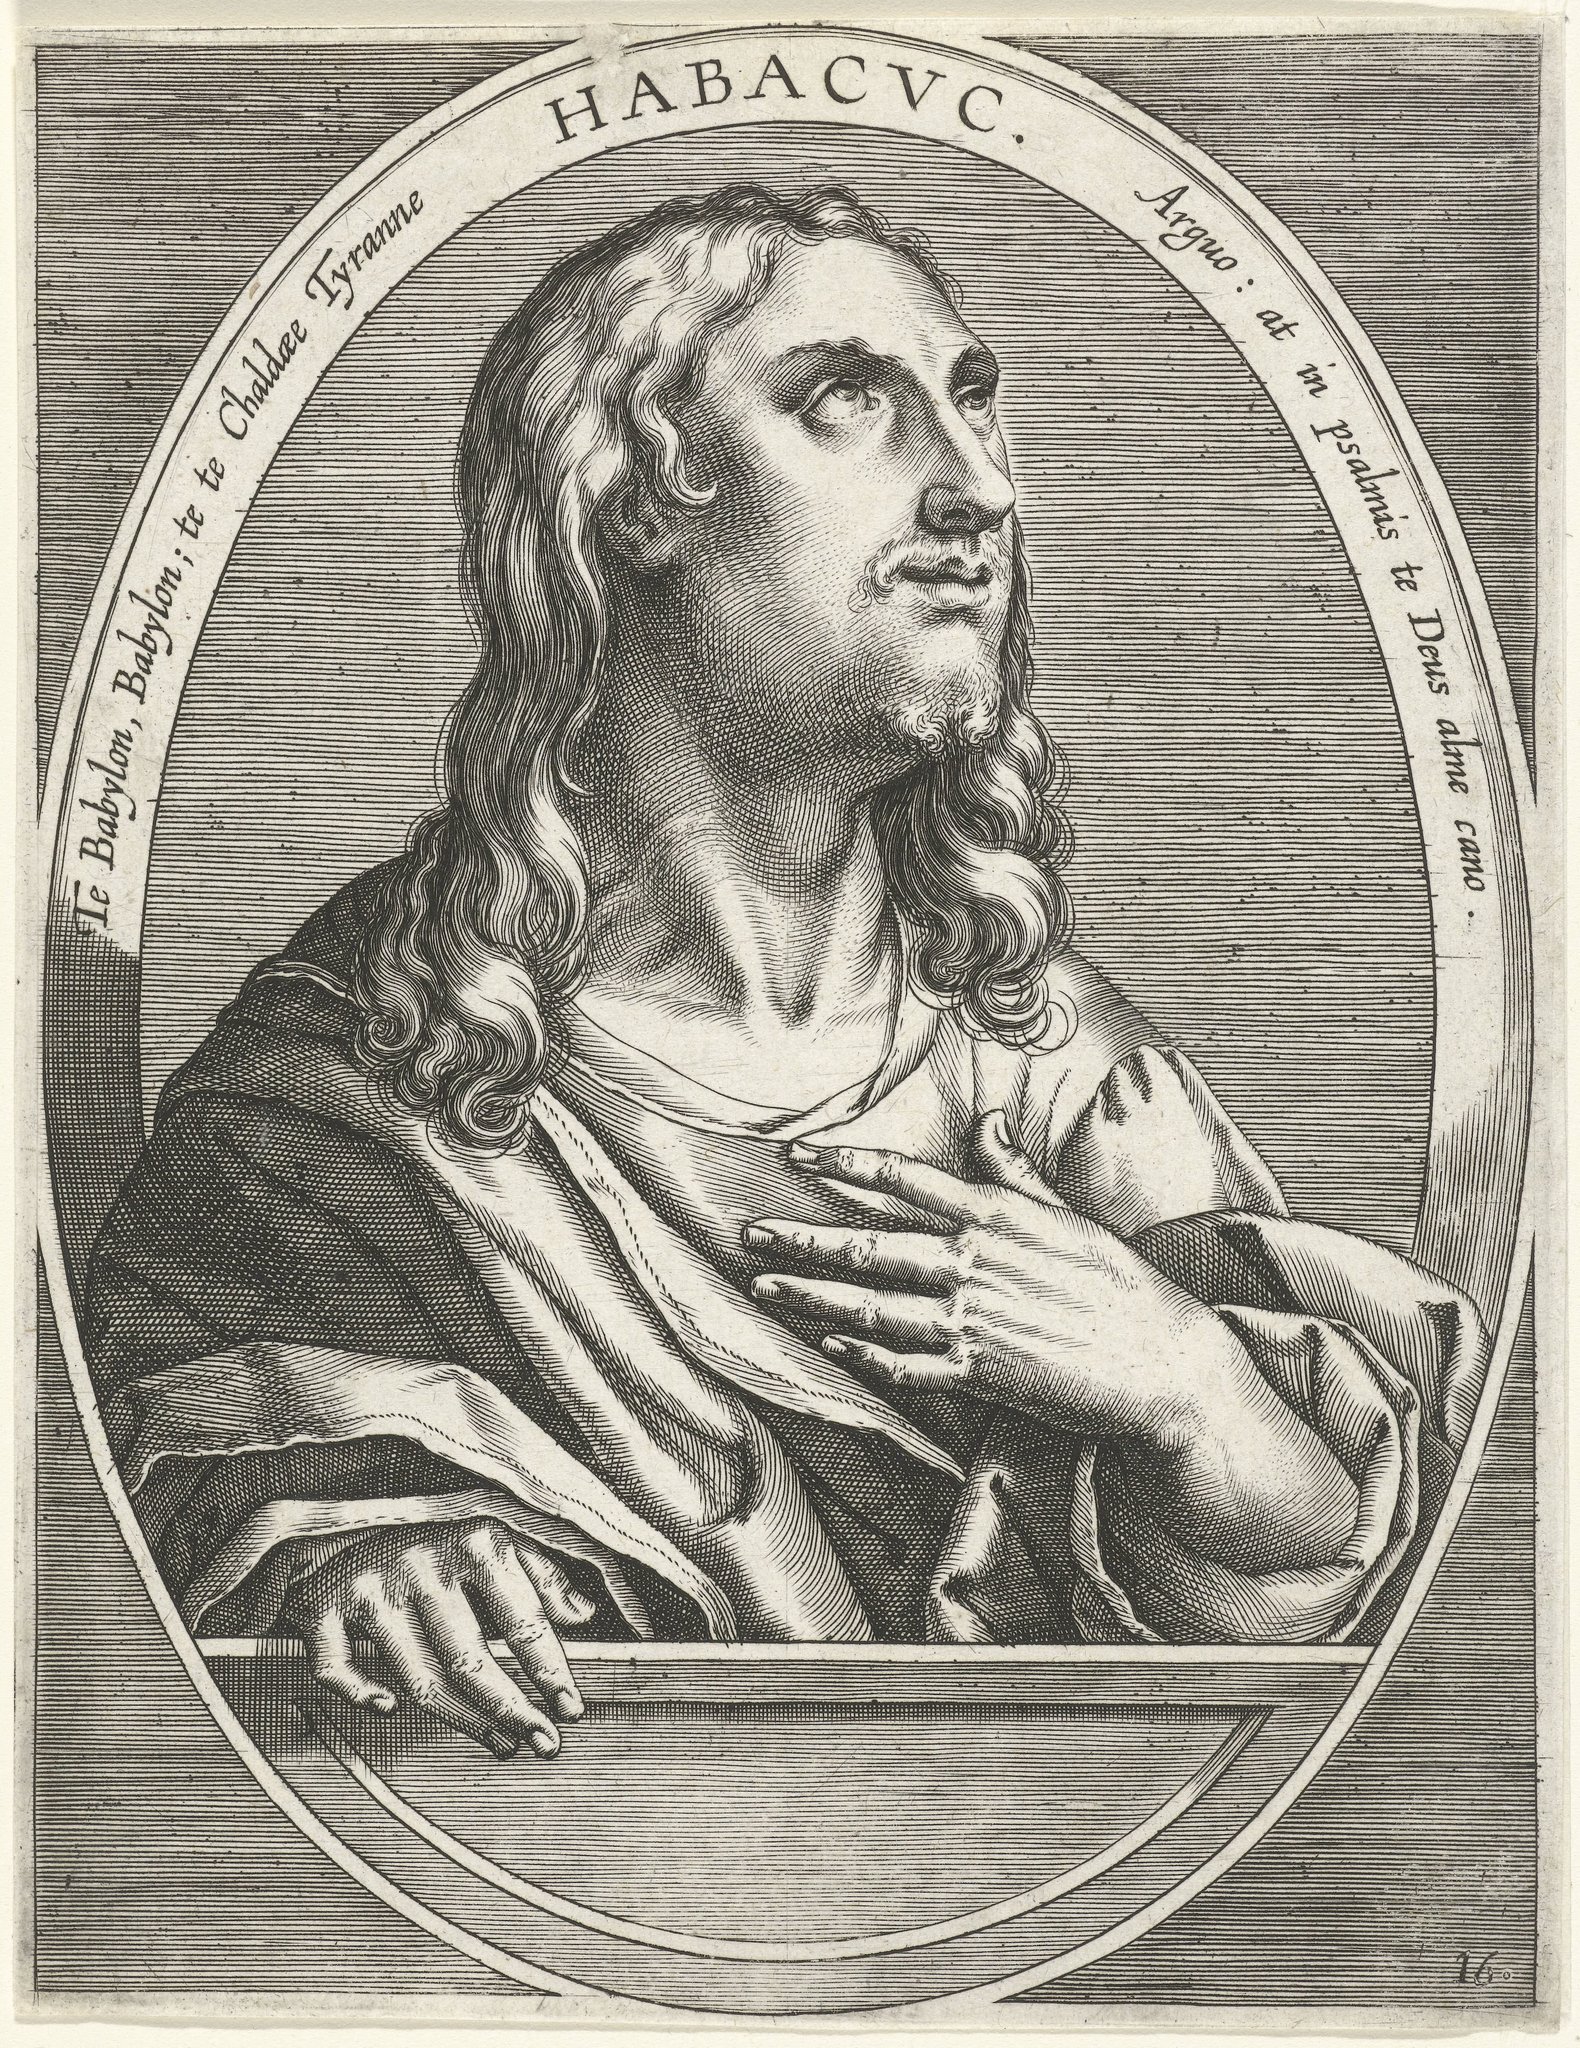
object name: print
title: Icones Prophetarum Veteris Testamenti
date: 1613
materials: paper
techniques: engraving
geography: antwerp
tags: male persons from the old testament (with name) (not in biblical context)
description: De profeet Habakuk, in ovaal met Latijns randschrift. De profeet heeft zijn ogen naar boven gericht.